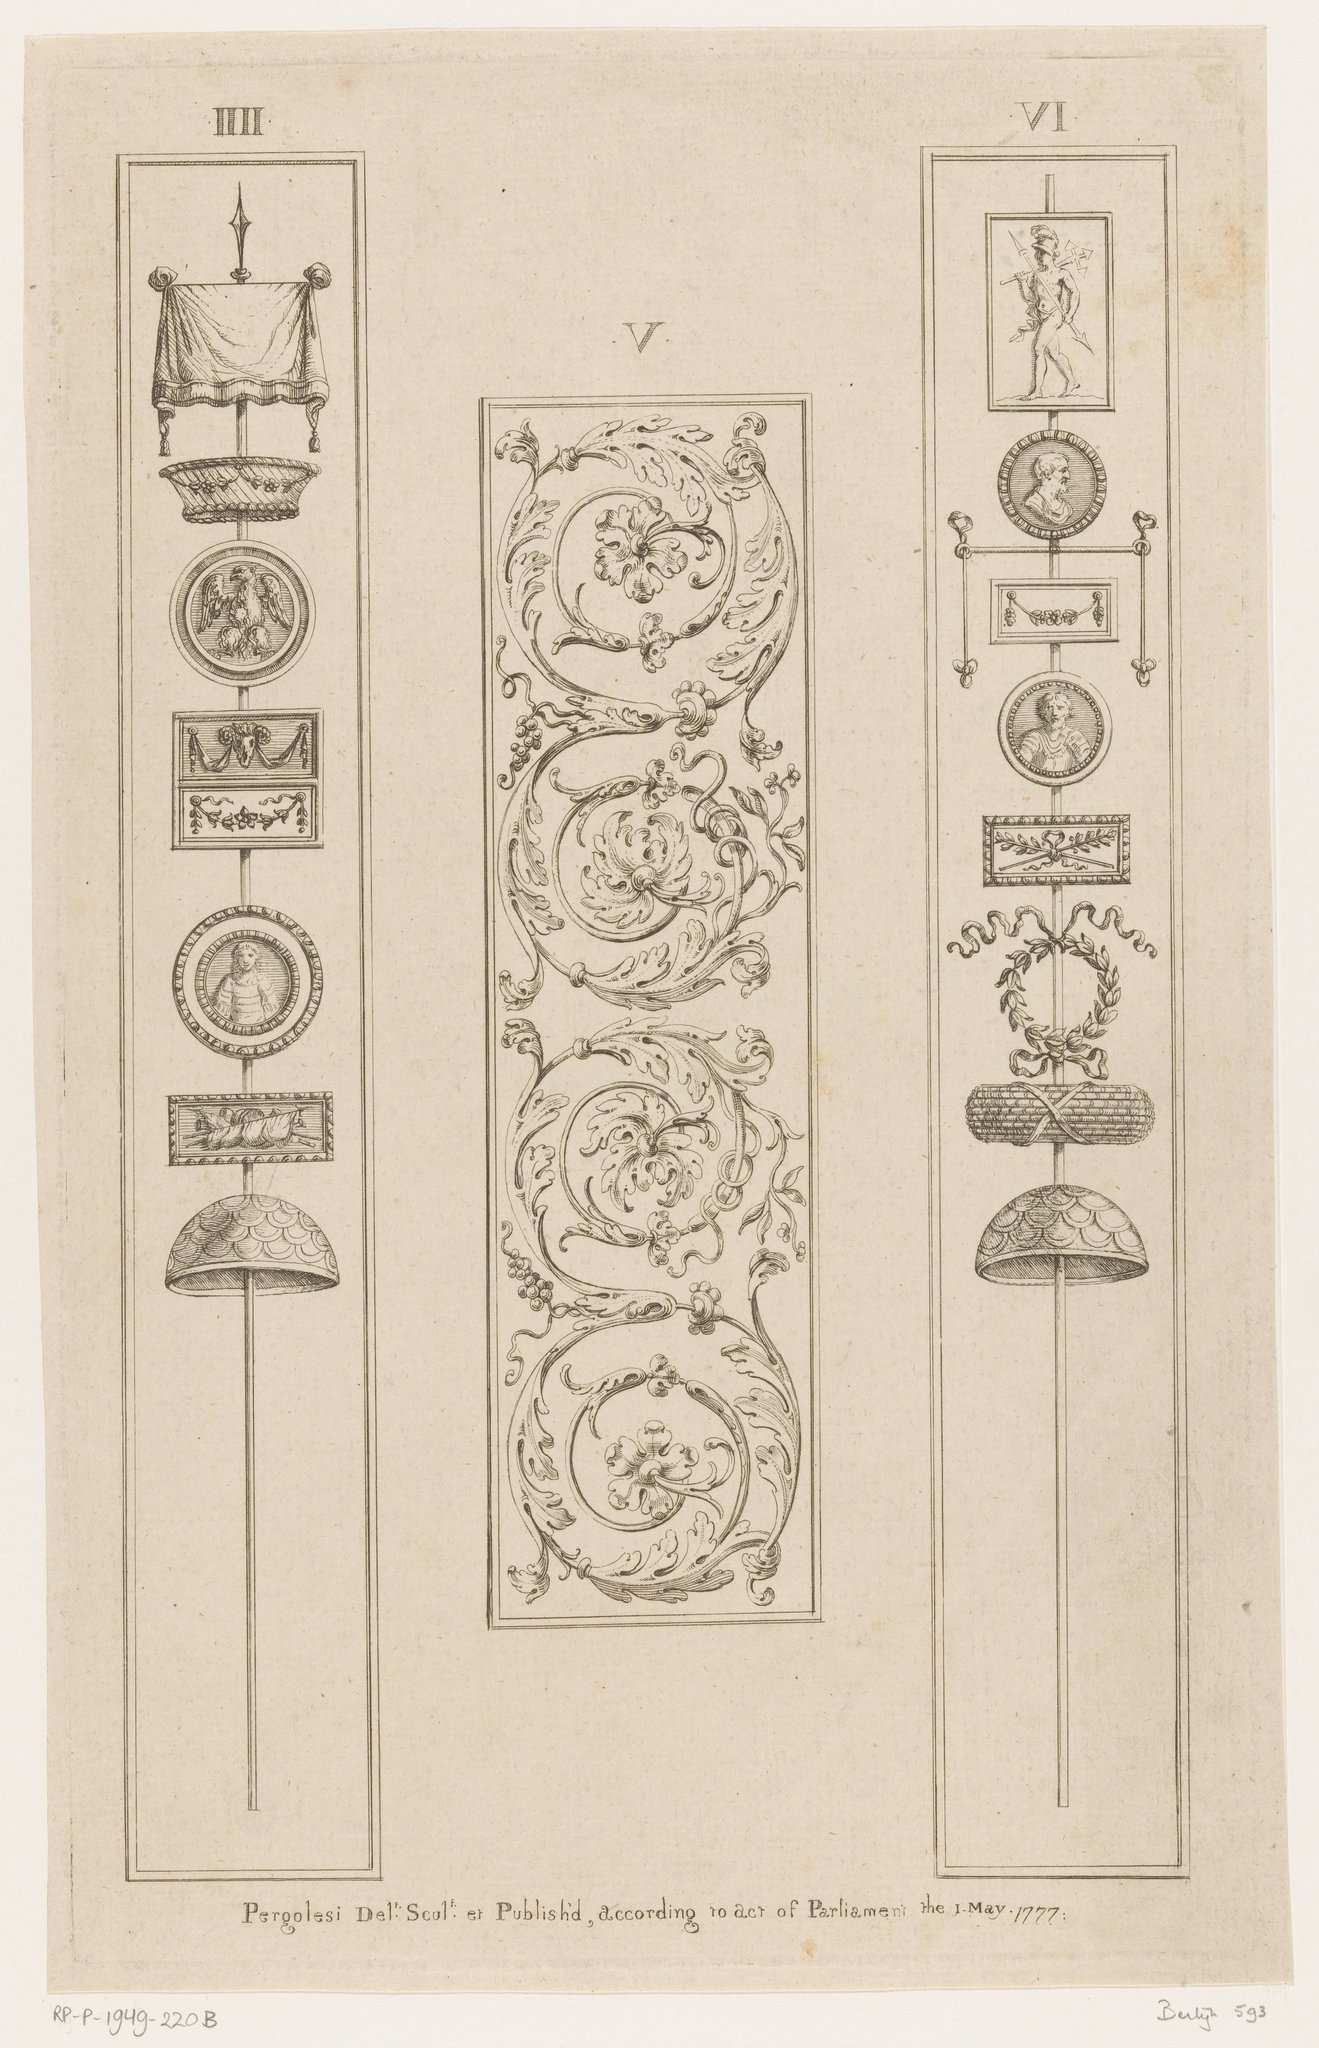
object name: ornament print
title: Arabesken en siersperen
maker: michelangelo pergolesi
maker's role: print maker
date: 1777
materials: paper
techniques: etching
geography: italy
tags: ornaments ~ art, foliage ~ ornament, casting weapons: spear (+ variant)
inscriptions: collector's mark: Lugt 2228, collector's mark: Lugt 1403b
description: Blad met drie genummerde voorstellingen naast elkaar. IIII: een sierspeer met medaillons. V: arabesken. VI: een stok met medaillons en een lauwerkrans.